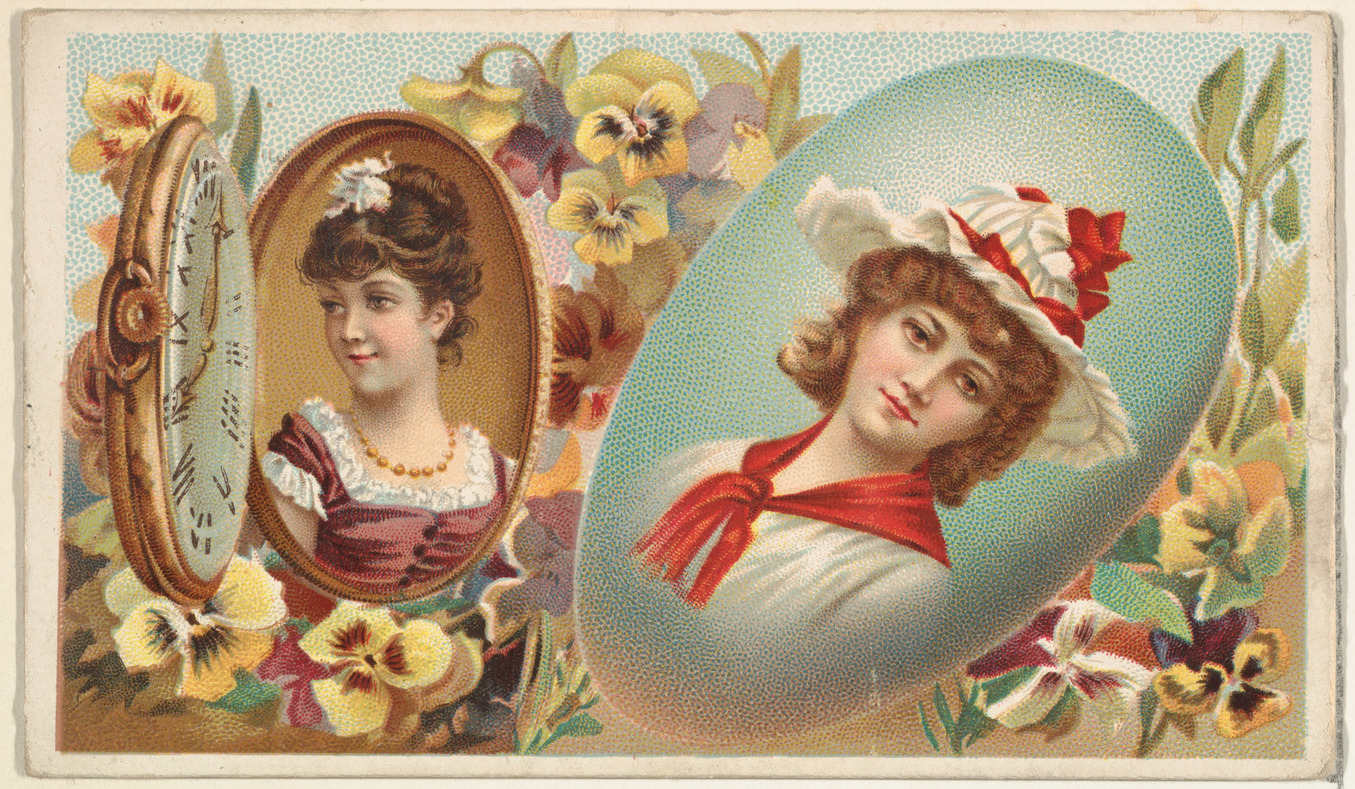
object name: print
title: Pocket Watch, from the Miniature Novelties series (N120) issued by Duke Sons & Co. to promote Honest Long Cut Tobacco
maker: w. duke, sons & co.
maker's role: publisher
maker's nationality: american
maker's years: 1870-1920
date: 1891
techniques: color lithograph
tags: pocket watches,women